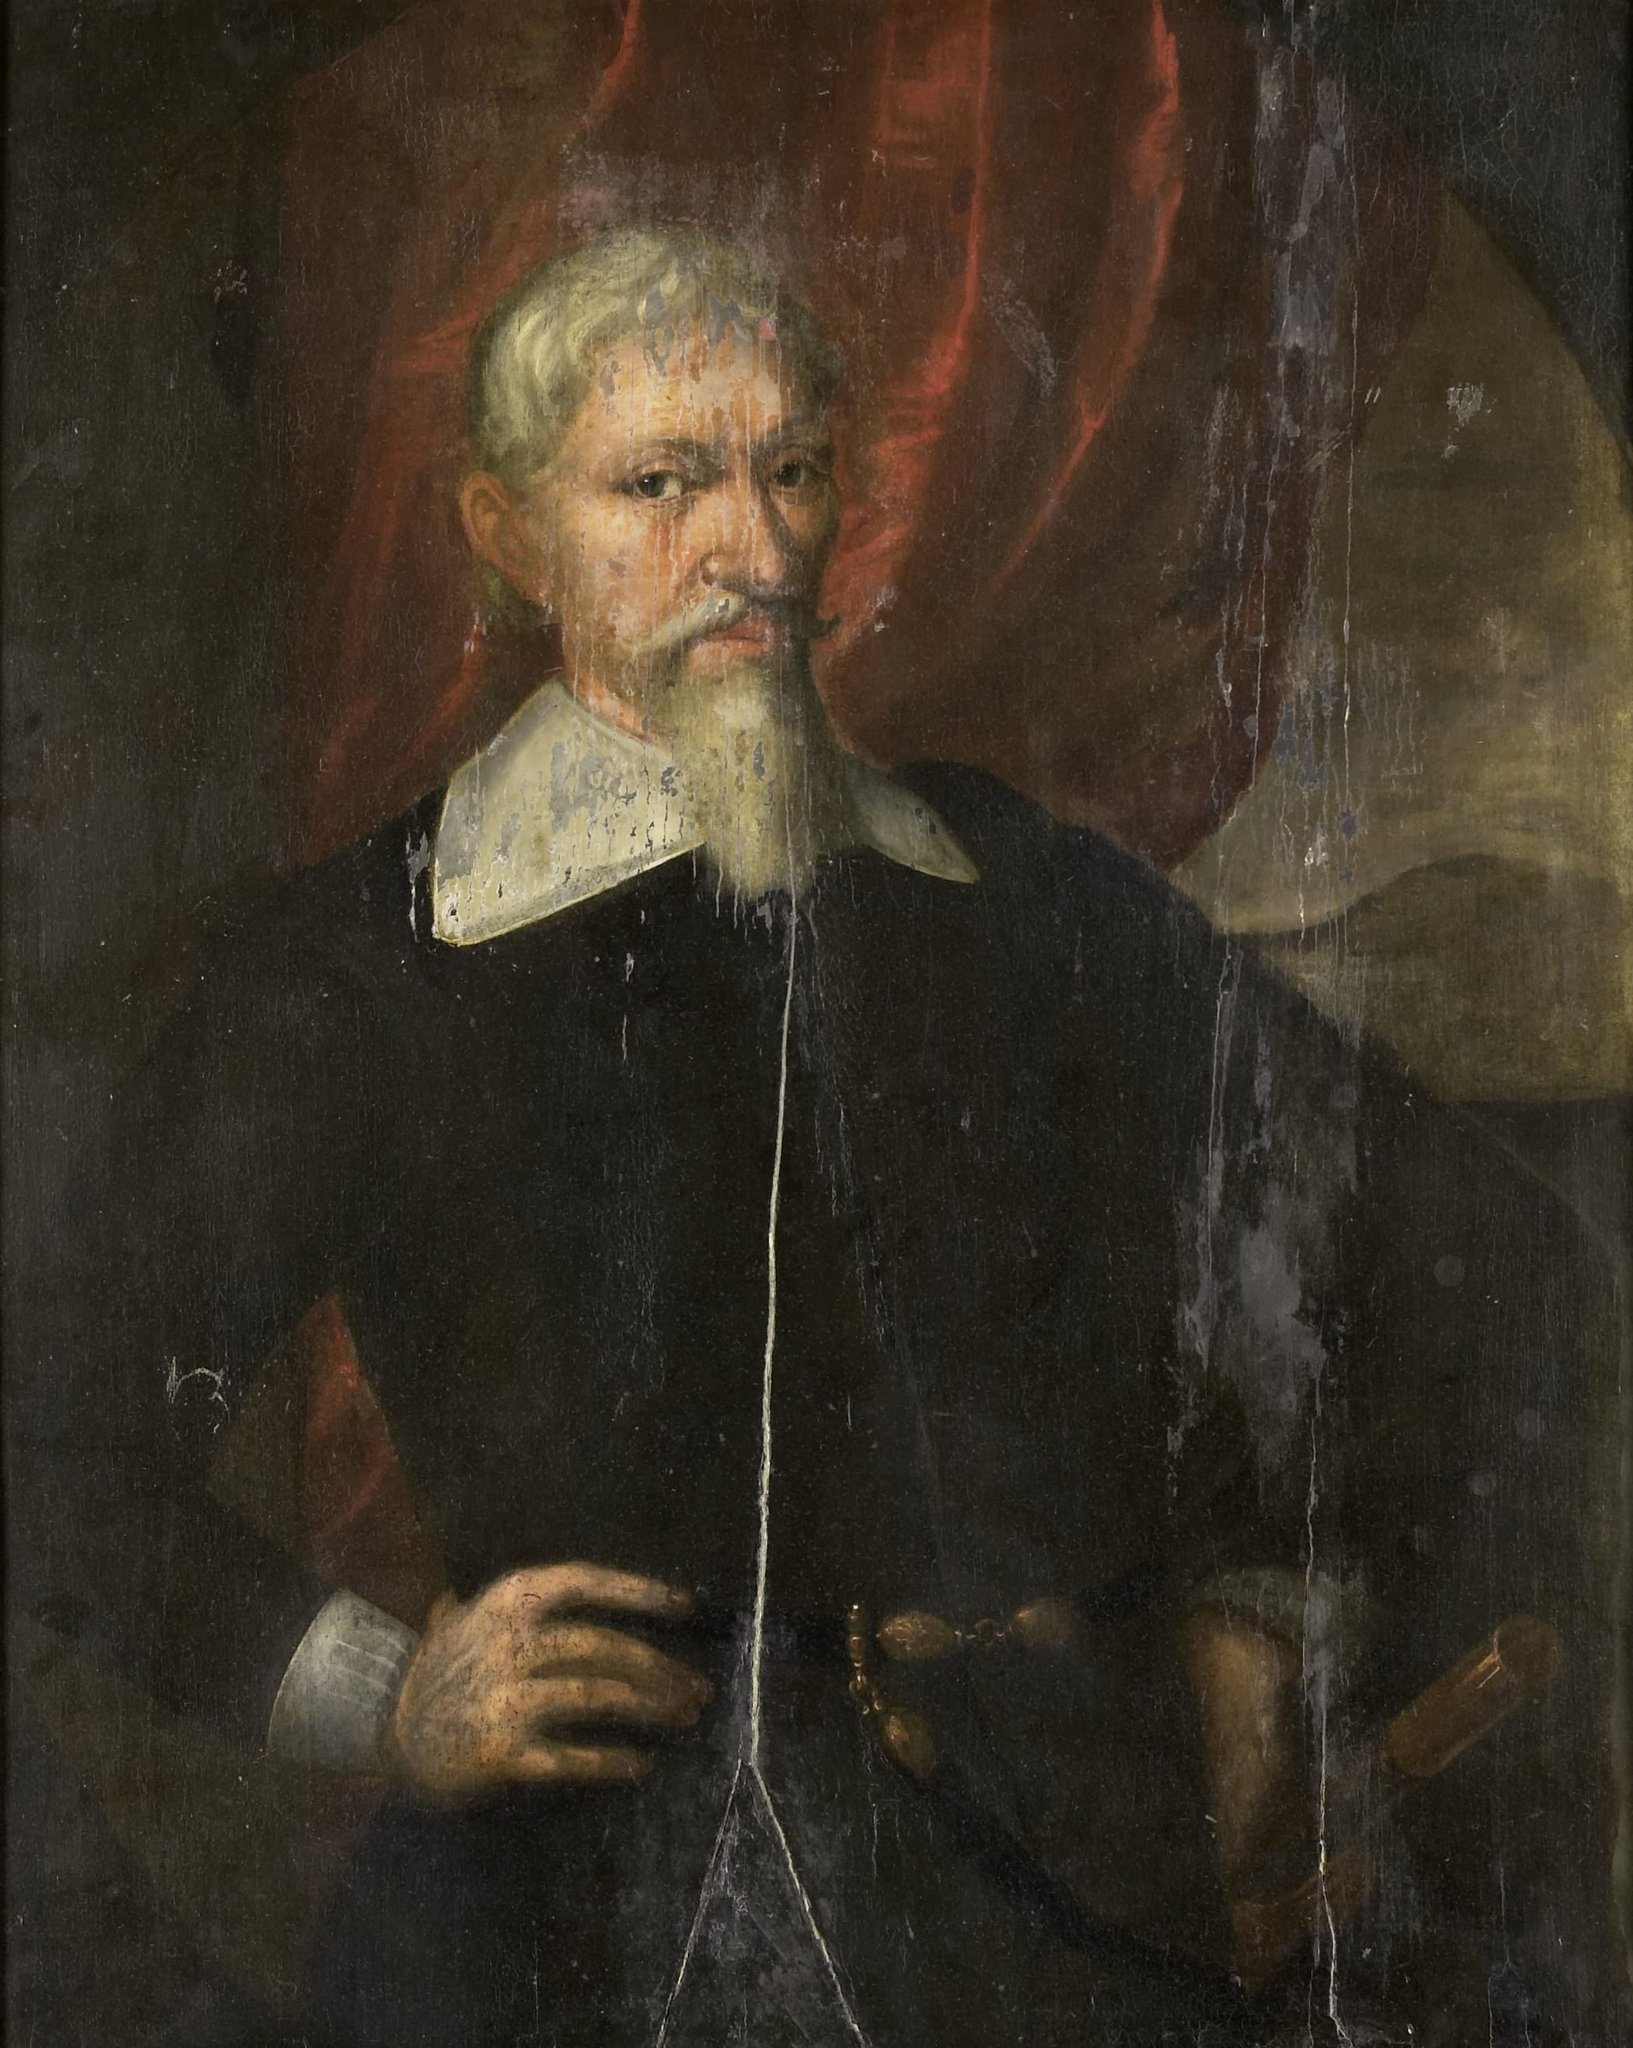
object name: painting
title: Portrait of Hendrik Brouwer, Governor-General of the Dutch East Indies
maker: Anonymous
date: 1632-1675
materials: oil, panel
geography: netherlands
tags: colonial governor, historical persons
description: Portret van Hendrik Brouwer (1581-1643). Gouverneur-generaal (1632-36). Staand, ten halven lijve, iets naar rechts. De rechterhand in de zij, commadostaf in de linkerhand. Onderdeel van een reeks van portretten van de gouverneurs-generaal van het voormalige Nederlands Oost-Indië.